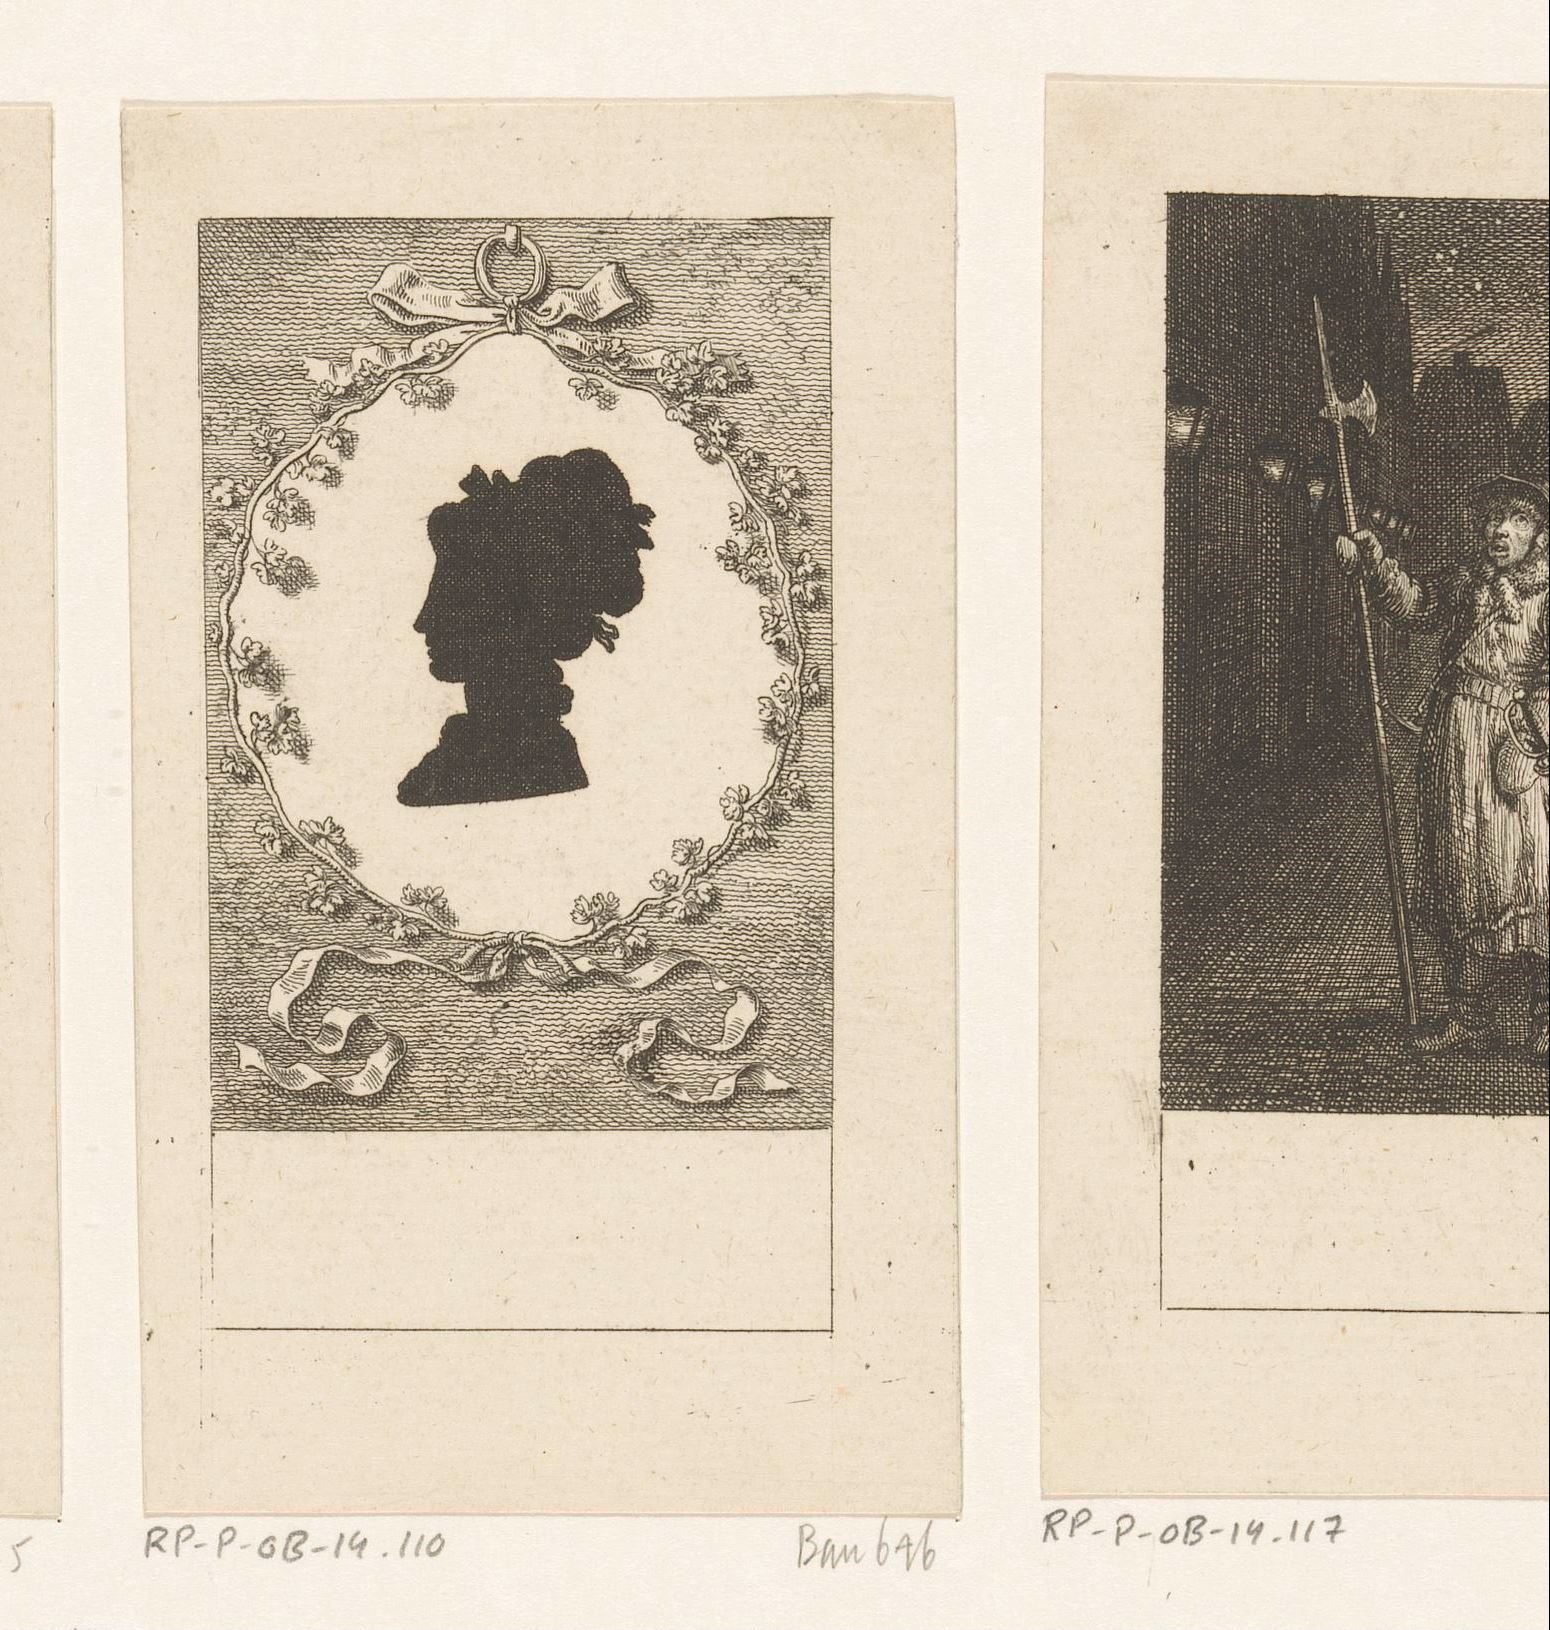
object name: print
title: Silhoutportret van een vrouw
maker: daniel nikolaus chodowiecki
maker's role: draughtsman, print maker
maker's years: 1726-1801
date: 1779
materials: paper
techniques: etching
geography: berlin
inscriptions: collector's mark: Lugt 2228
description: Tiende prent afkomstig uit een serie van twaalf verschillende prenten. De scènes zijn op een plaat geëtst. Een latere staat van deze serie is ook gebruikt in: Lauenburger genealogischen Kalender auf das Jahr 1780.